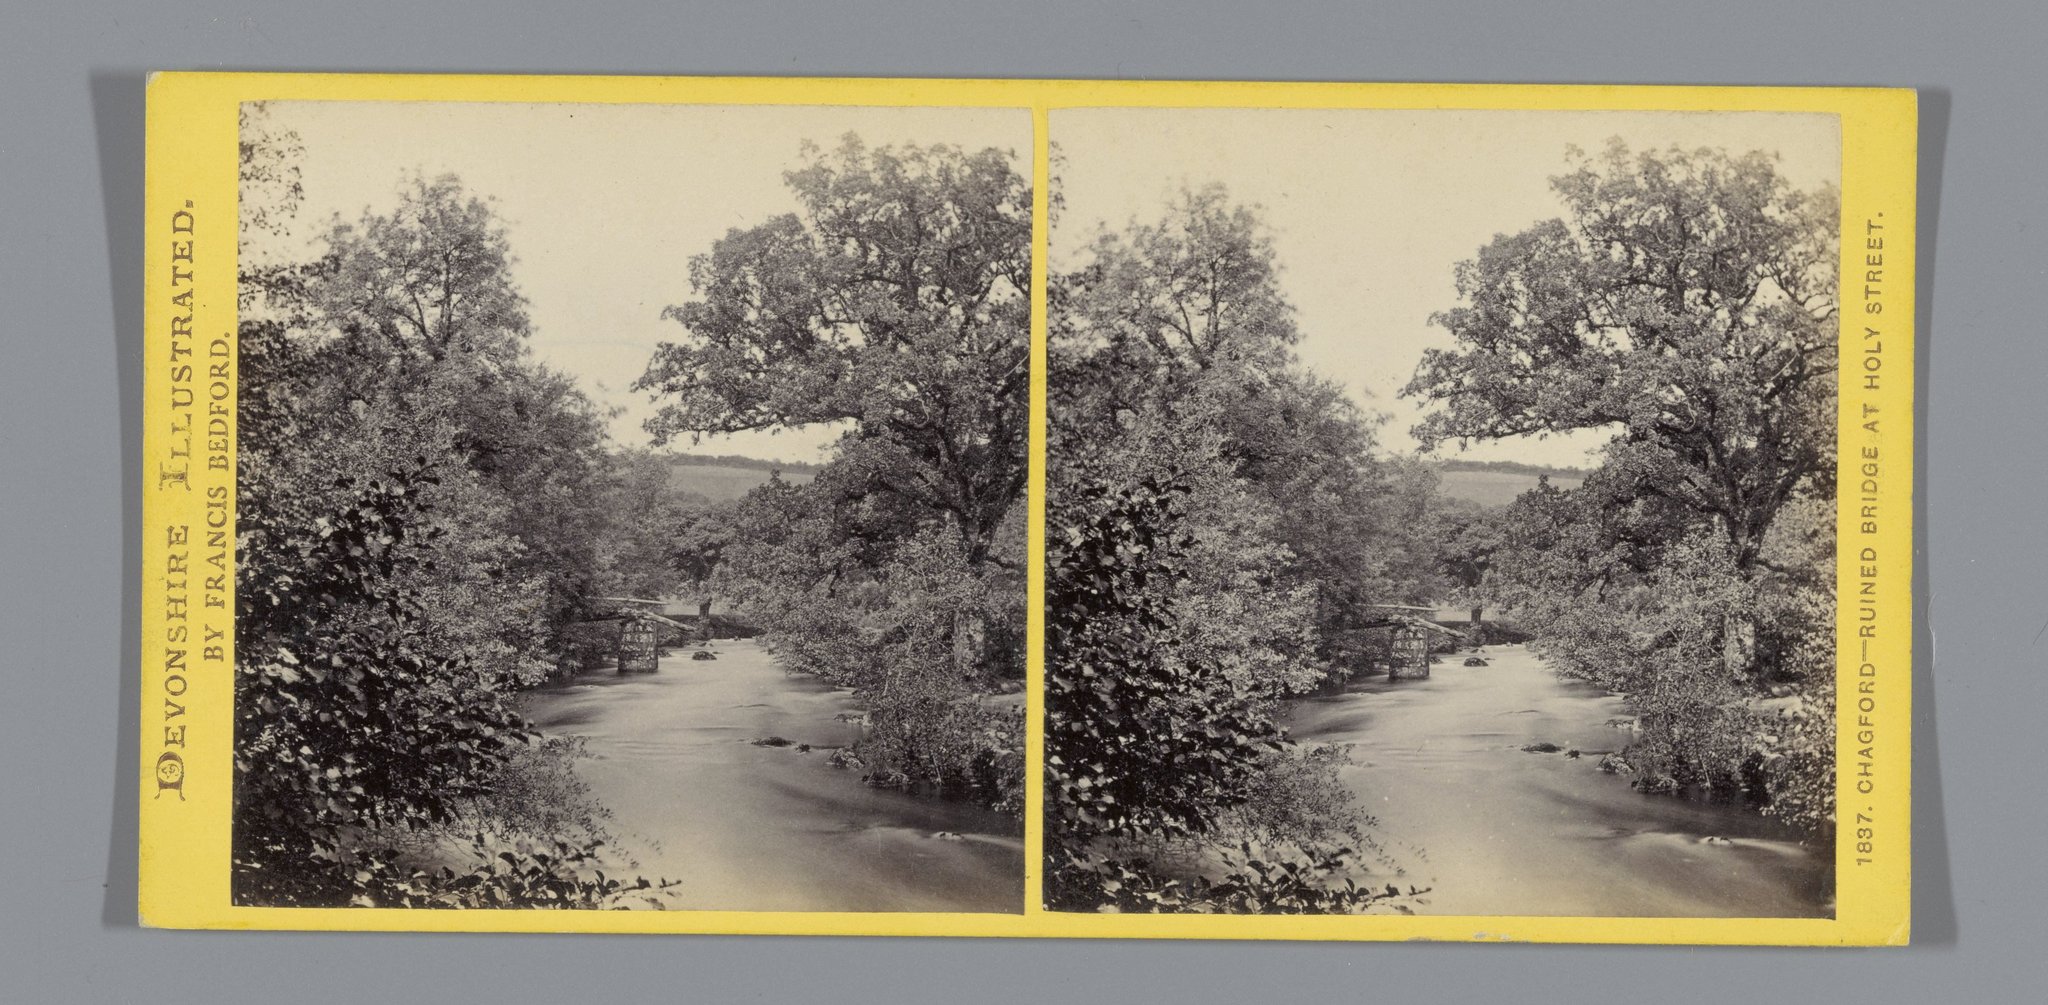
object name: stereograph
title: Gezicht op de Meldon nabij Chagford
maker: francis bedford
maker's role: print maker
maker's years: 1815-1894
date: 1850-1880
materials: cardboard, photographic support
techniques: albumen print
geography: chagford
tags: chagford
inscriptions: number: ‘1837.’, inscription: ‘Devonshire Illustrated. by Francis Bedford.’